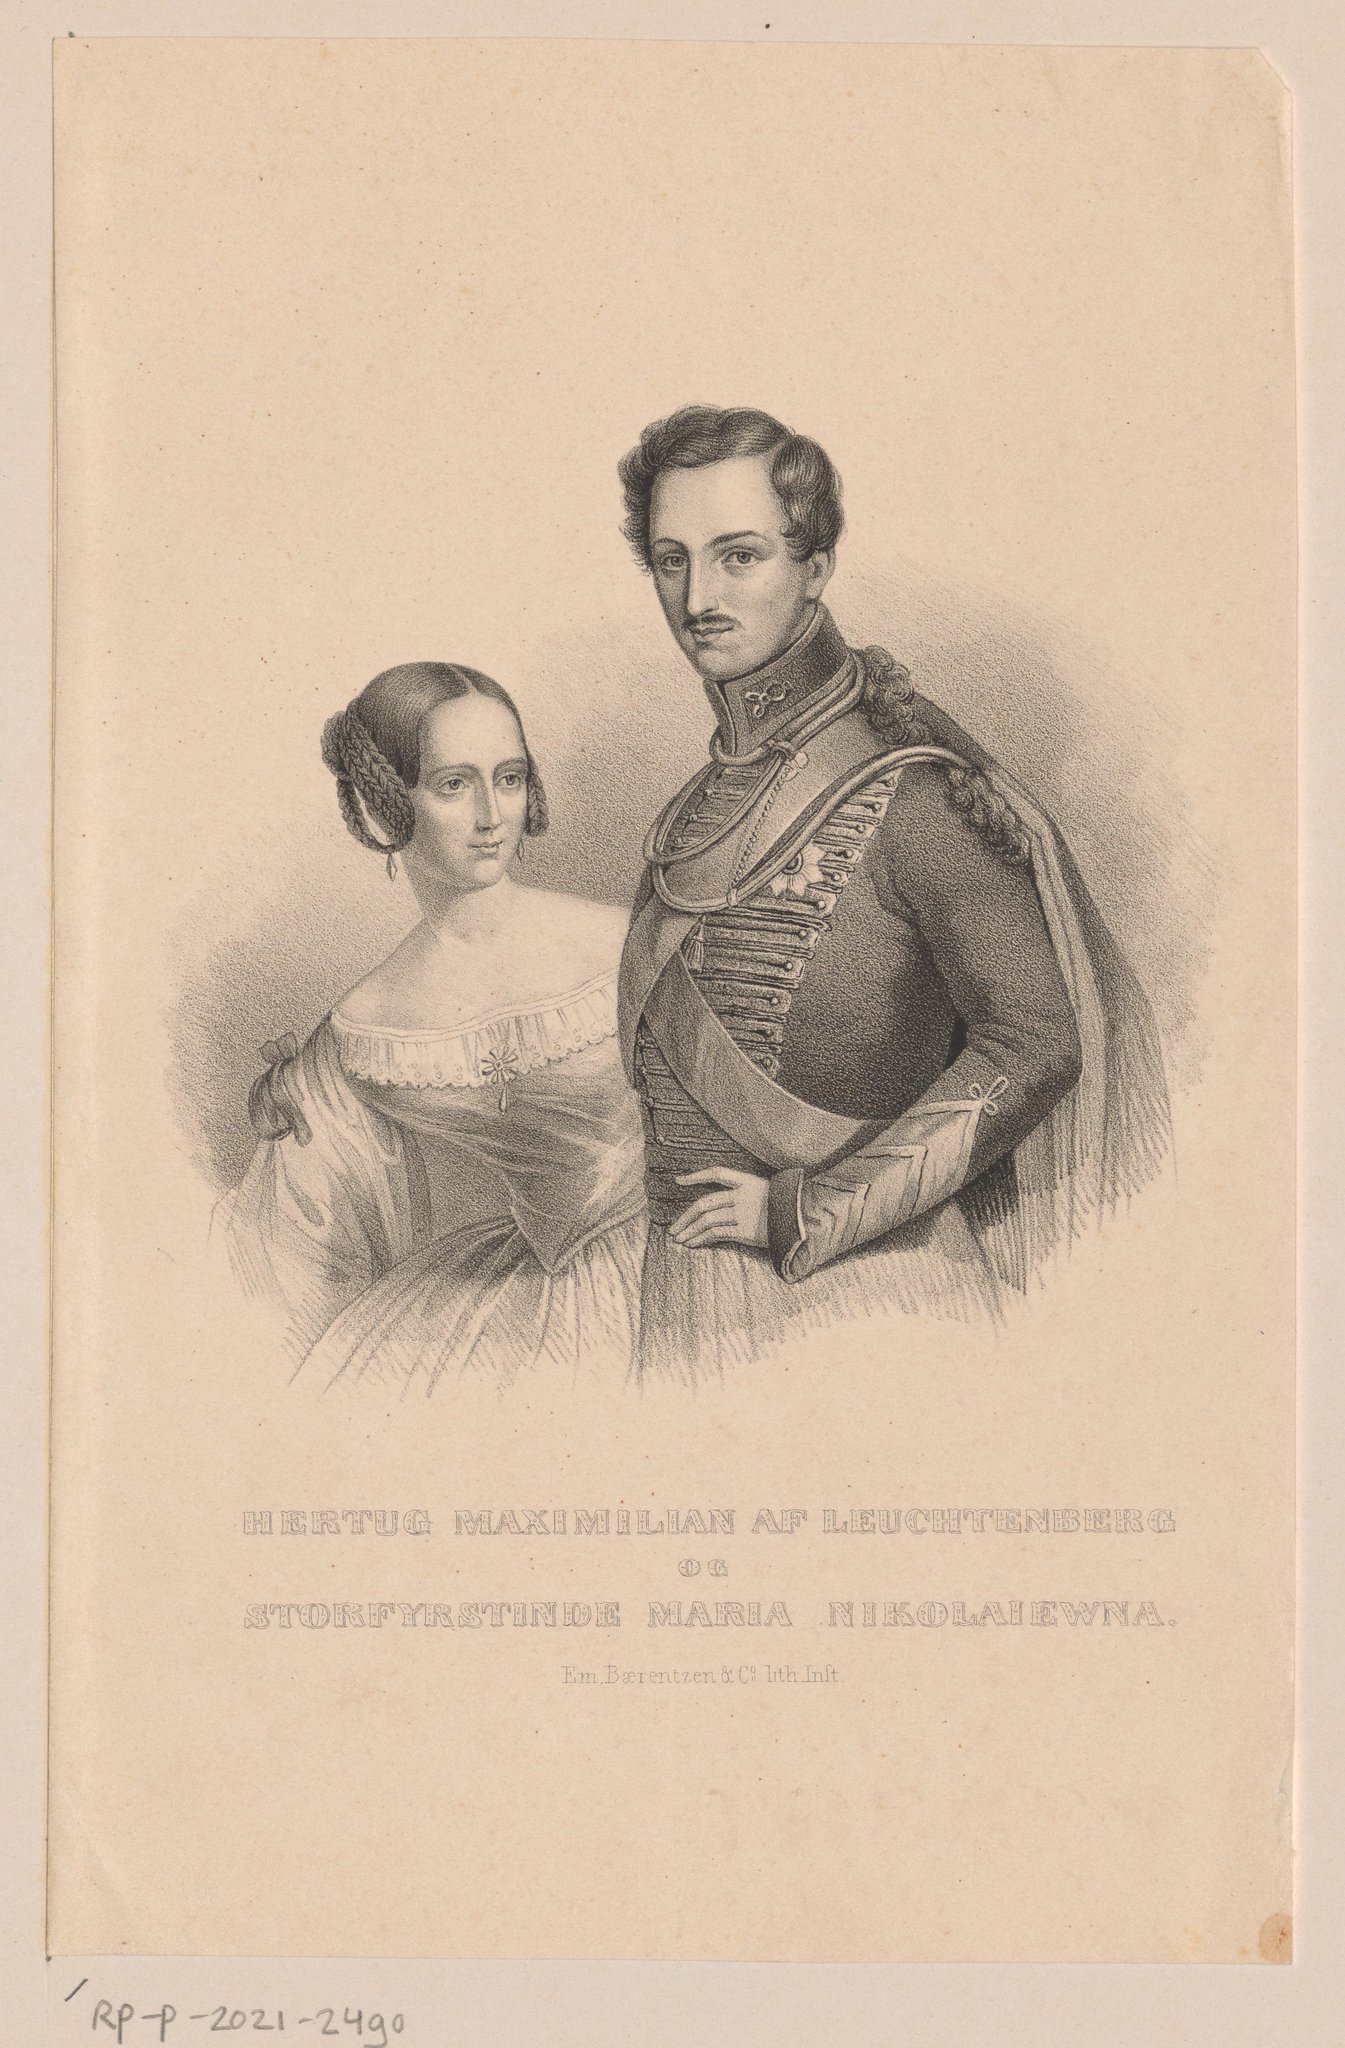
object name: print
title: Dubbelportret van Maria Nikolajevna van Rusland en Maximiliaan van Leuchtenberg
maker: Anonymous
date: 1839-1850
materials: paper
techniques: lithograph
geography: copenhagen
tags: historical persons - bb - woman, historical persons, (military) uniforms